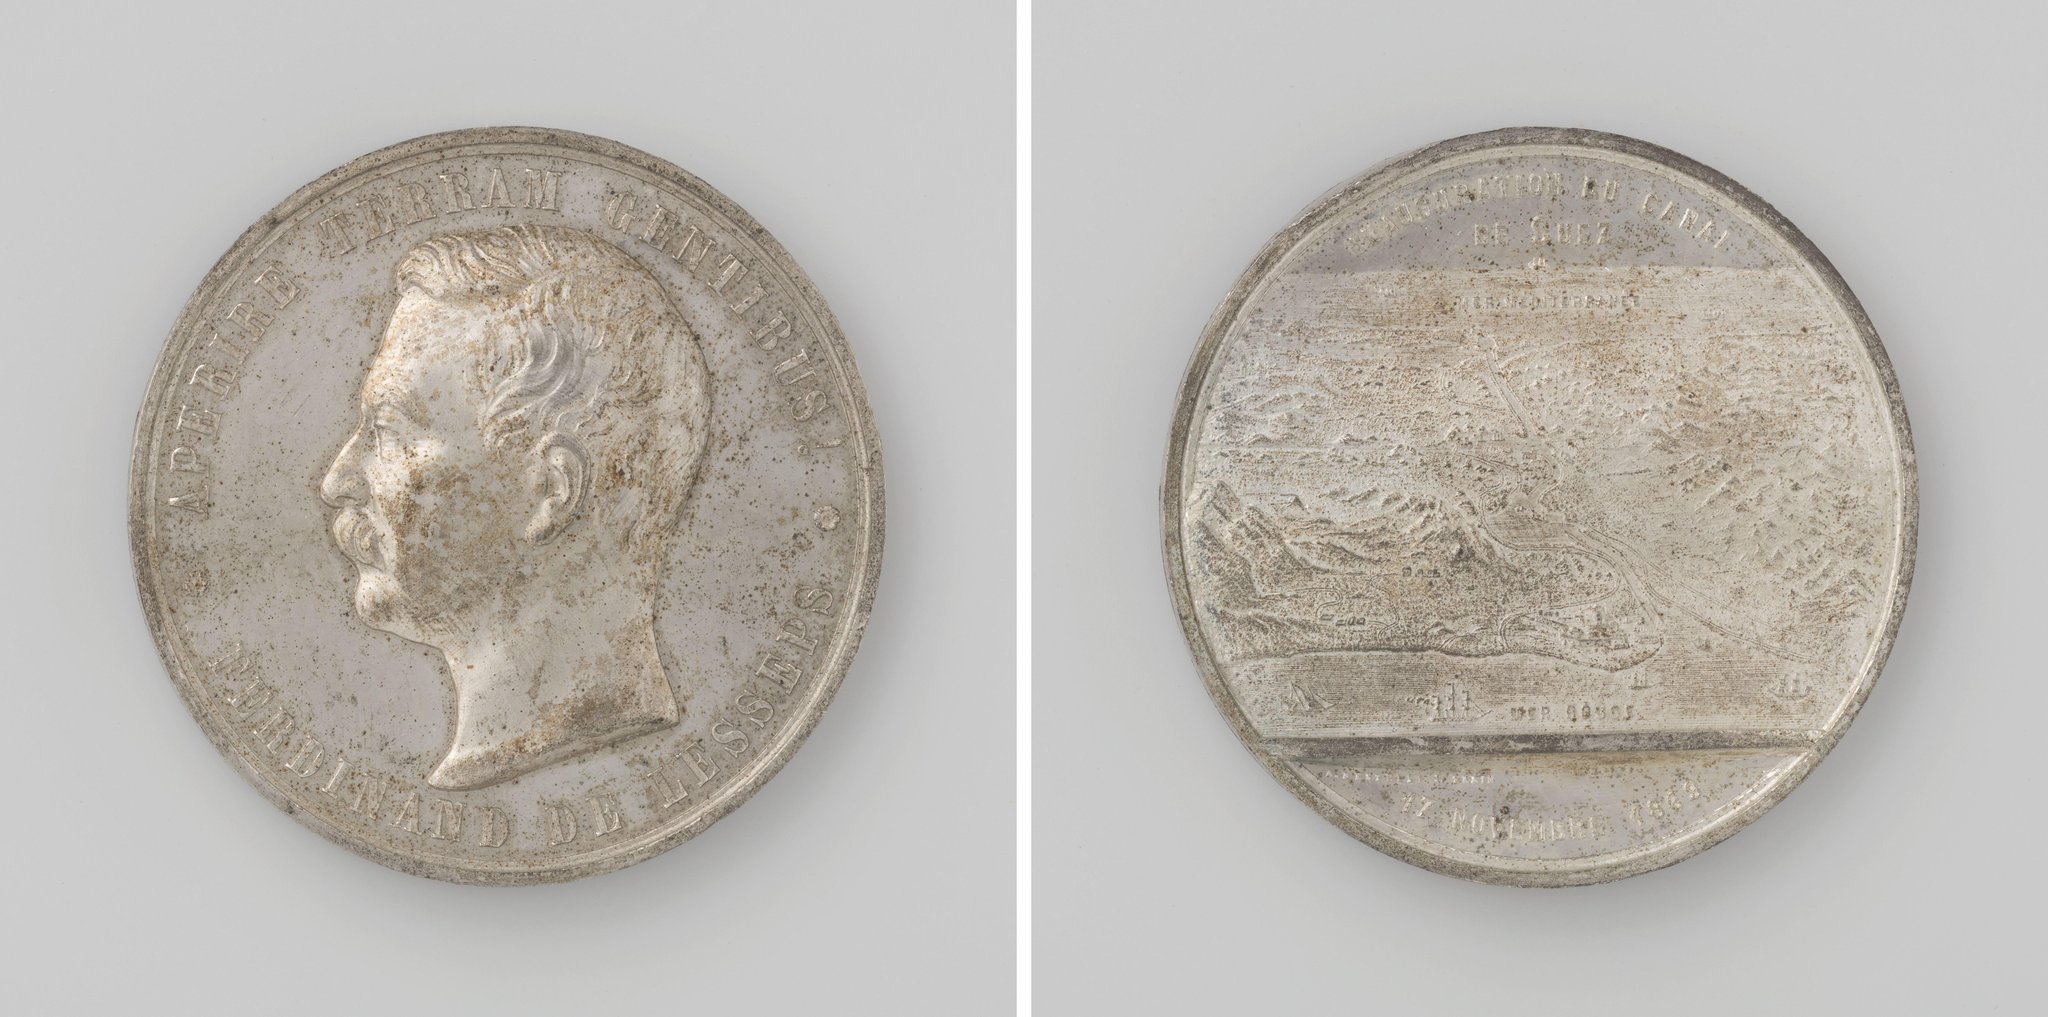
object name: history medal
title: Opening van het Suez-kanaal 1869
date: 1869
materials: tin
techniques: striking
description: Tinnen penning, op de voorzijde het portet van Ferdinand de Lesseps naar links met omschrift, op de keerzijde het Suez-kanaal vanaf de Rode Zee in vogelvlucht met onder en boven tekst.